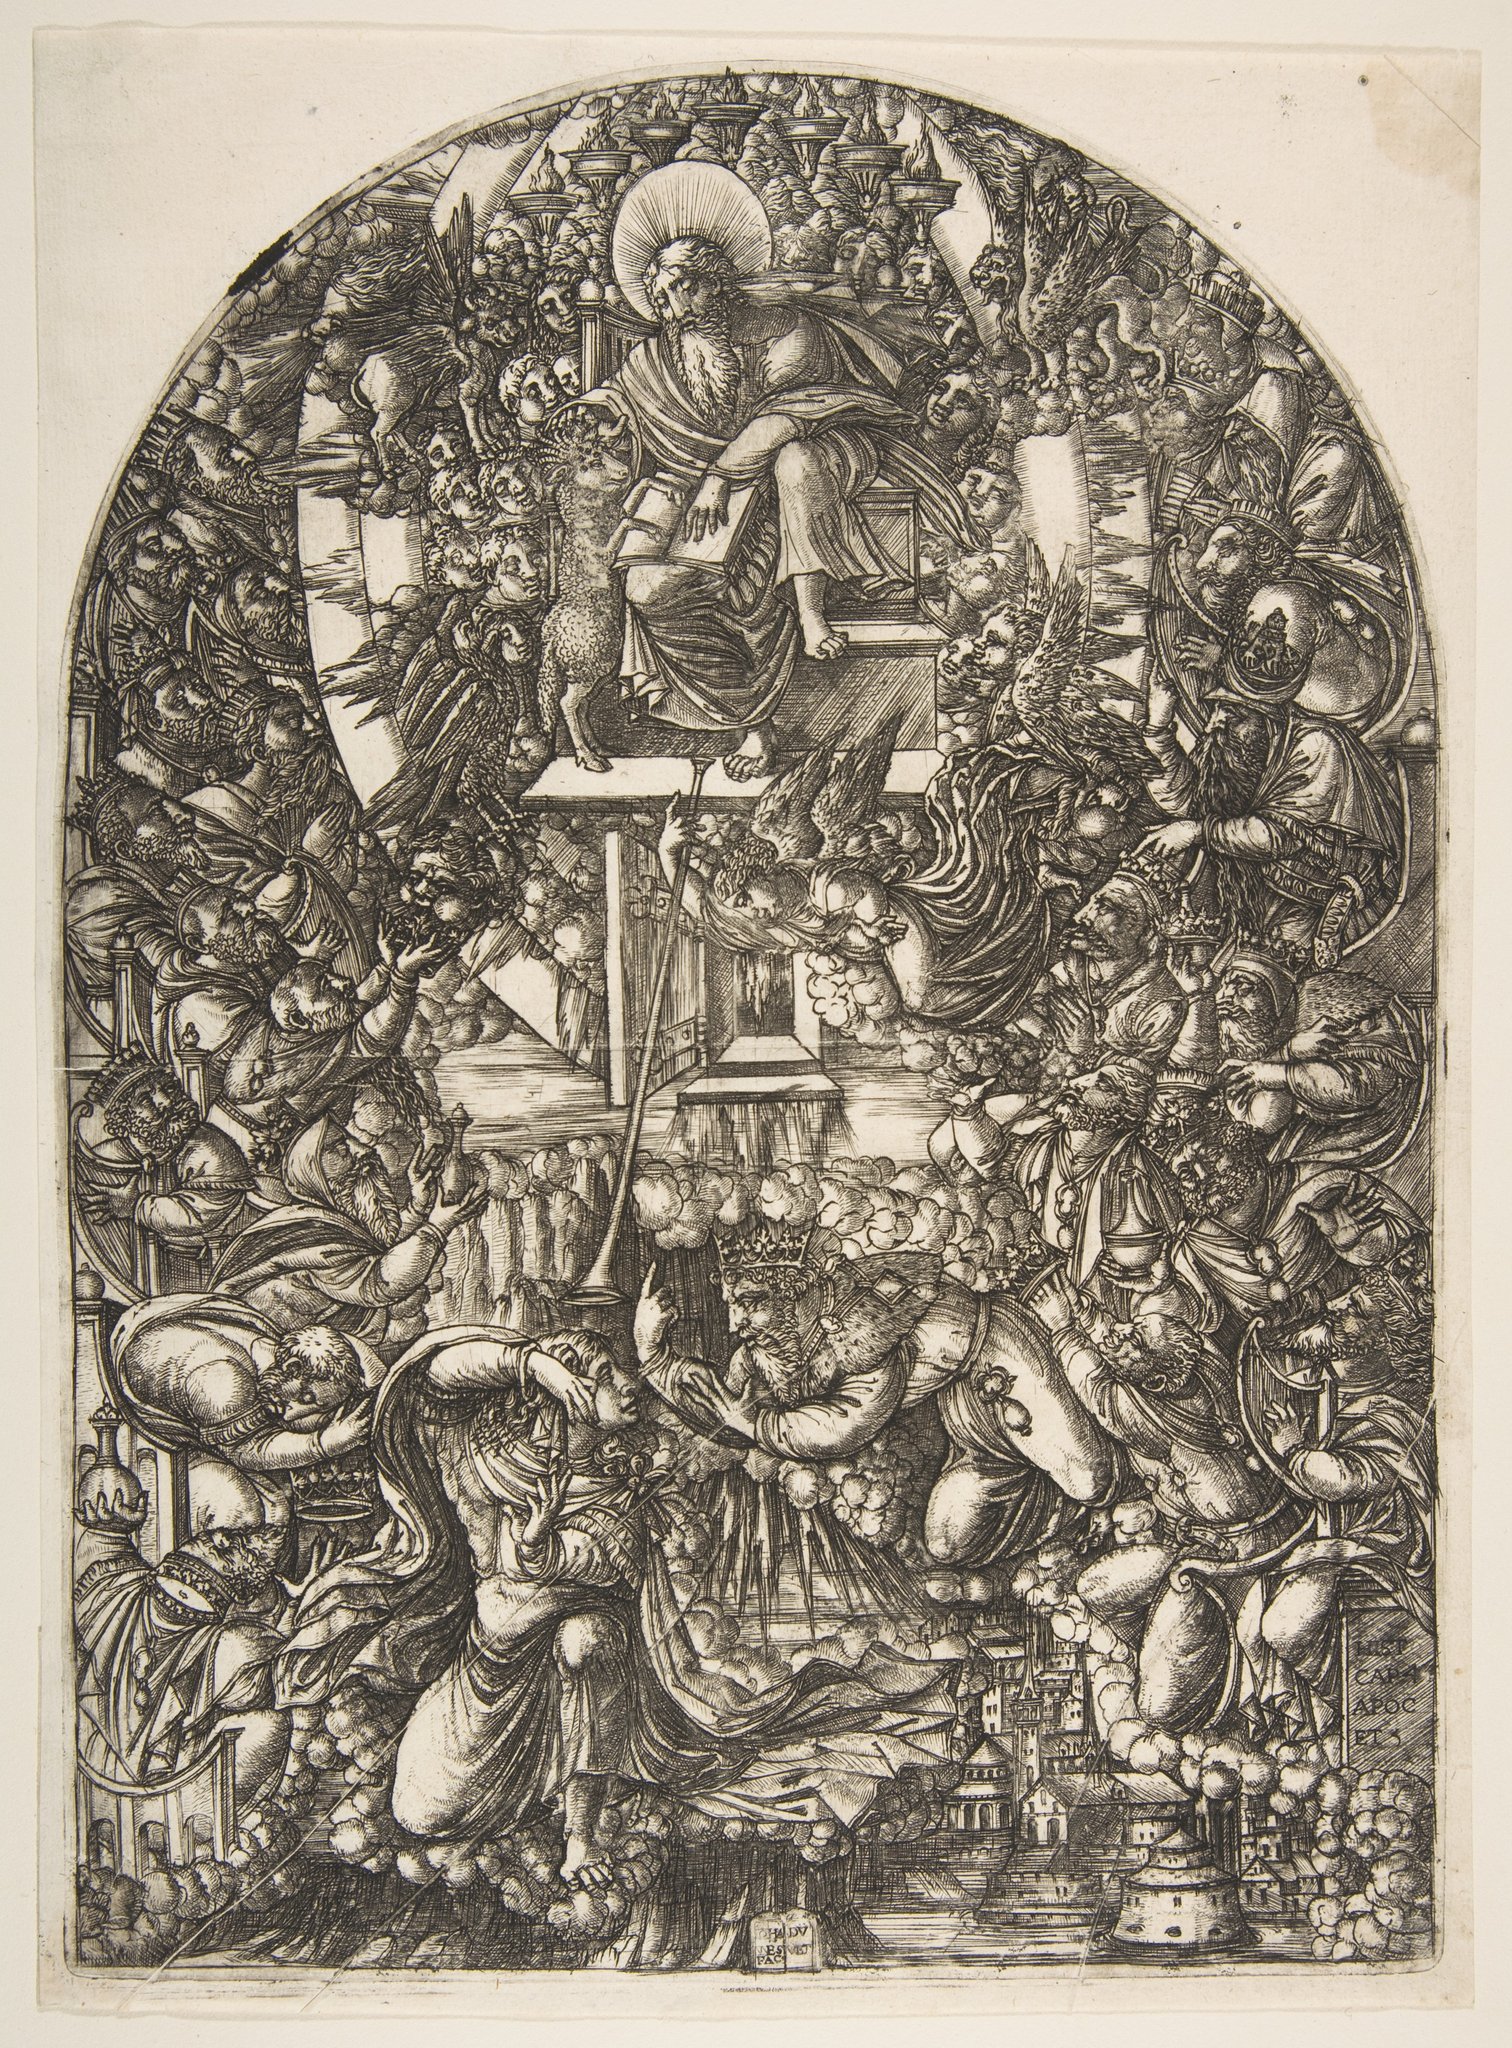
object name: print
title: Saint John Summoned to Heaven, from the Apocalypse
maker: jean duvet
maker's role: artist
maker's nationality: french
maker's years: 1485-1561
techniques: engraving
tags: saint john the baptist,heaven,apocalypse